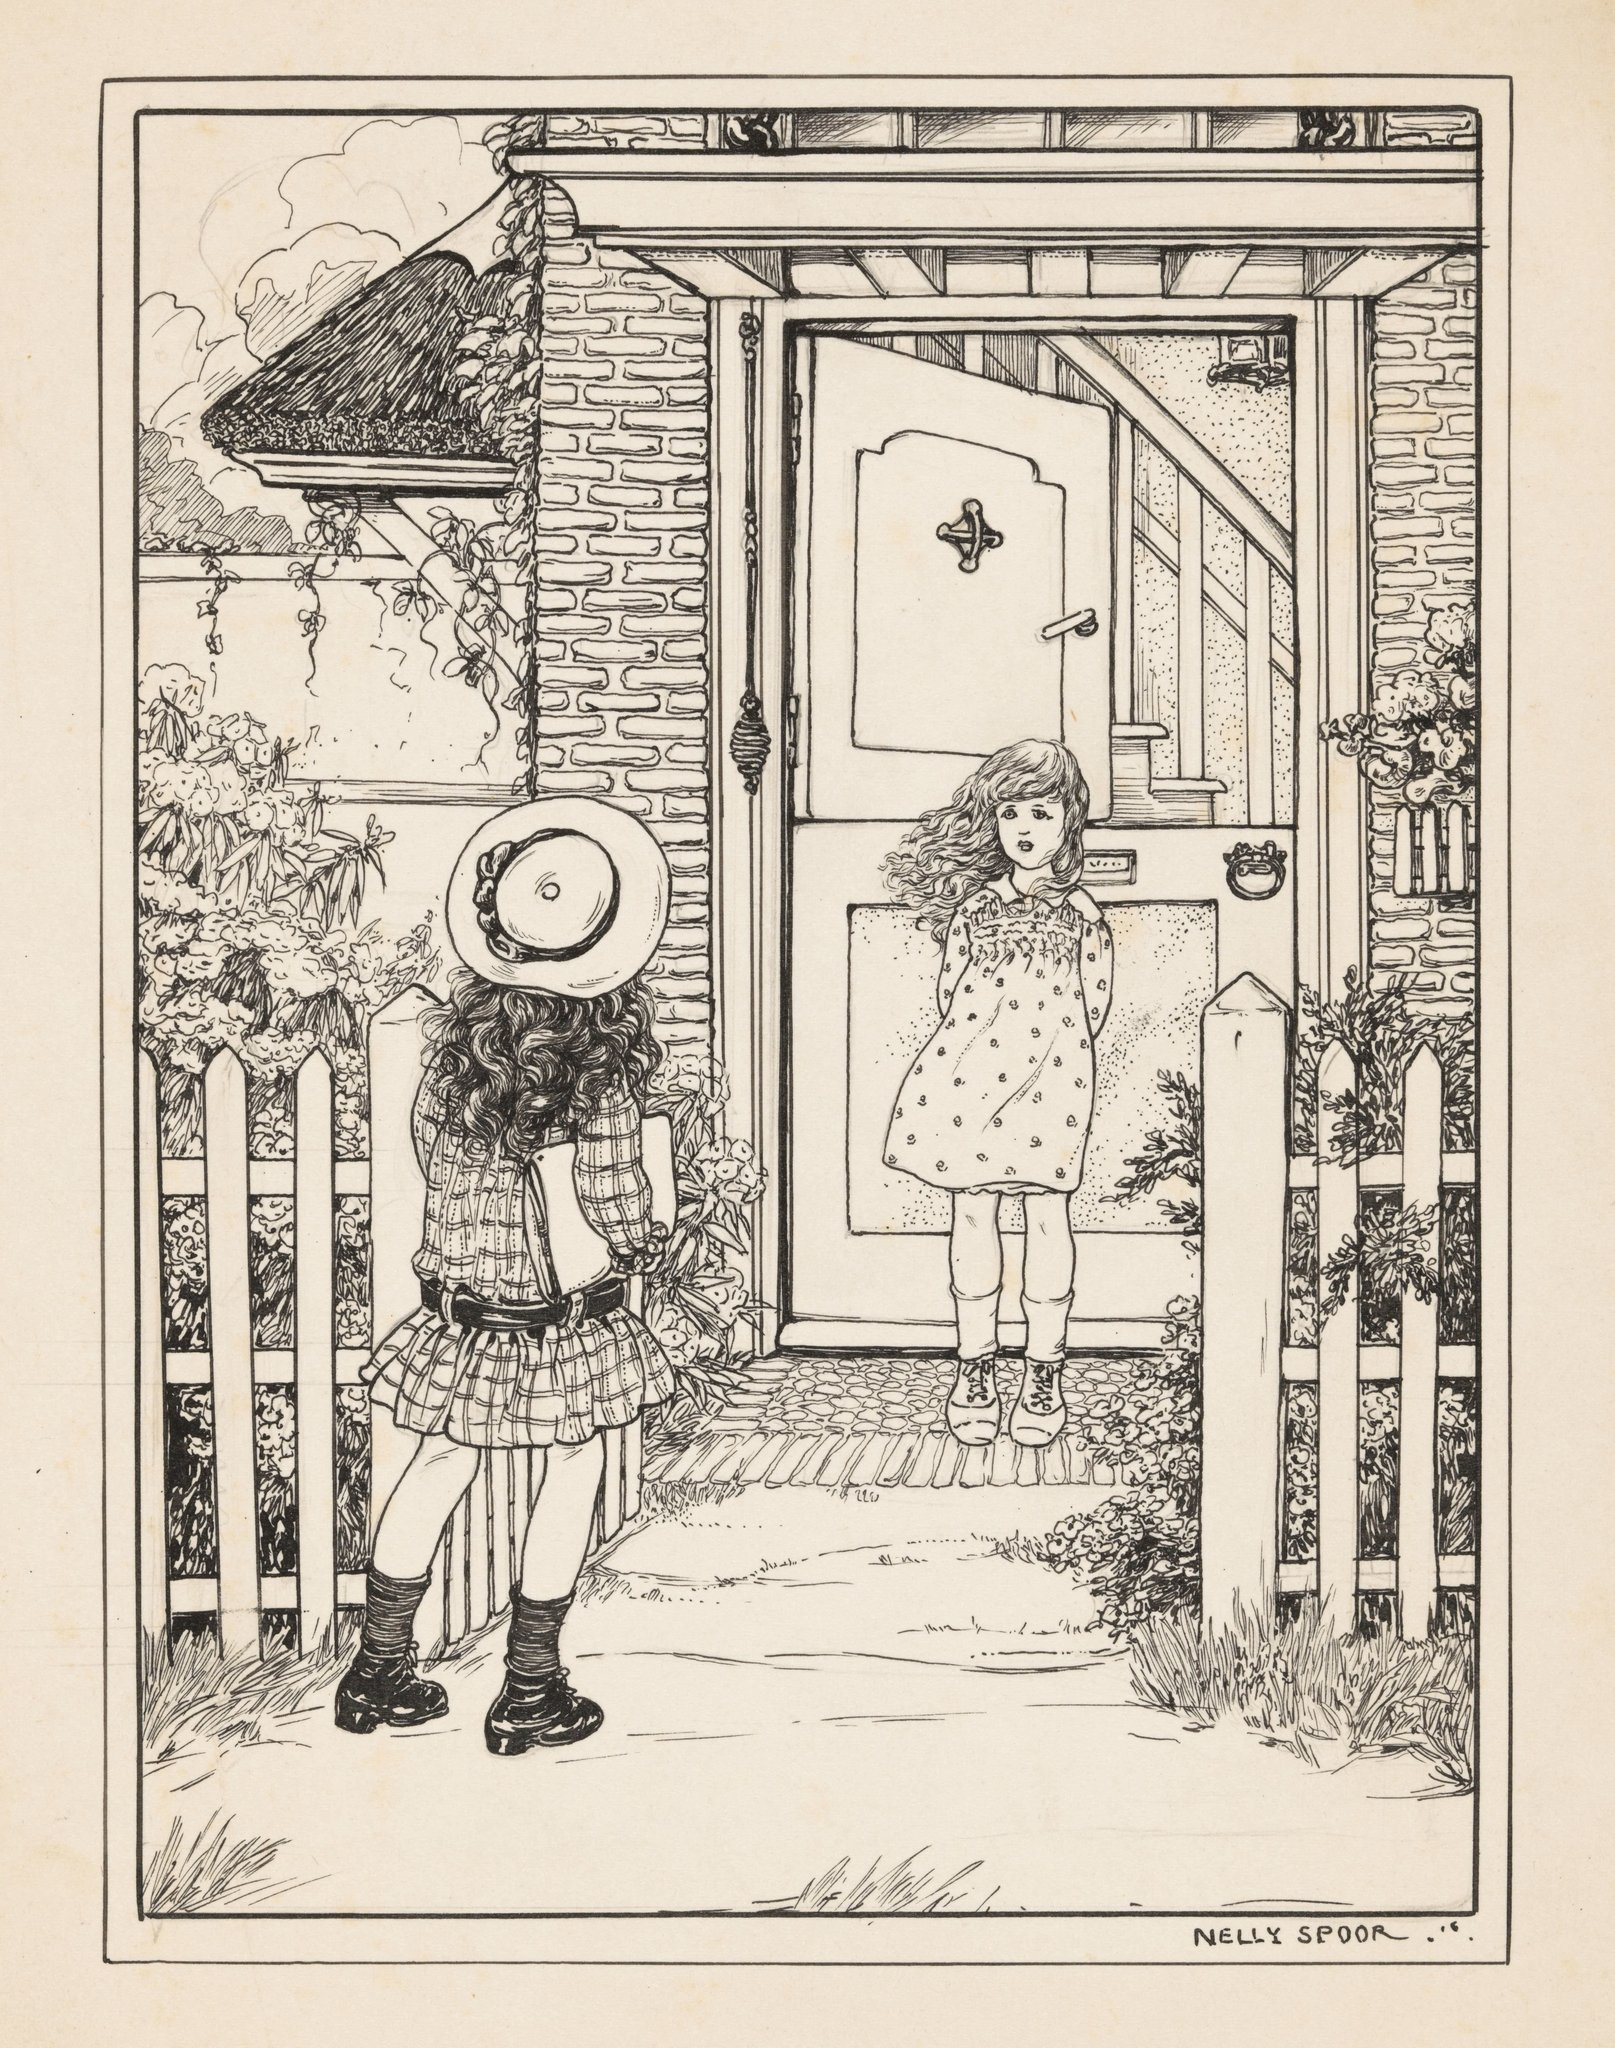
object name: boekillustratie ontwerp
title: Twee meisjes bij een voordeur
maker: nelly spoor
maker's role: draughtsman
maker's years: 1885-1950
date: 1916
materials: ink, paper, pencil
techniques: pen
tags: garden, fence, wall, paling, girl (child between toddler and youth), door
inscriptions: signature and date: ‘NELLY SPOOR . 16 .’, :, collector's mark: Lugt 2228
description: Een meisje staat op een tuinpad voor een deur waarvan de bovenste helft open staat. Ze kijkt naar een meisje met een tas onder de arm dat aan komt lopen langs een hek.